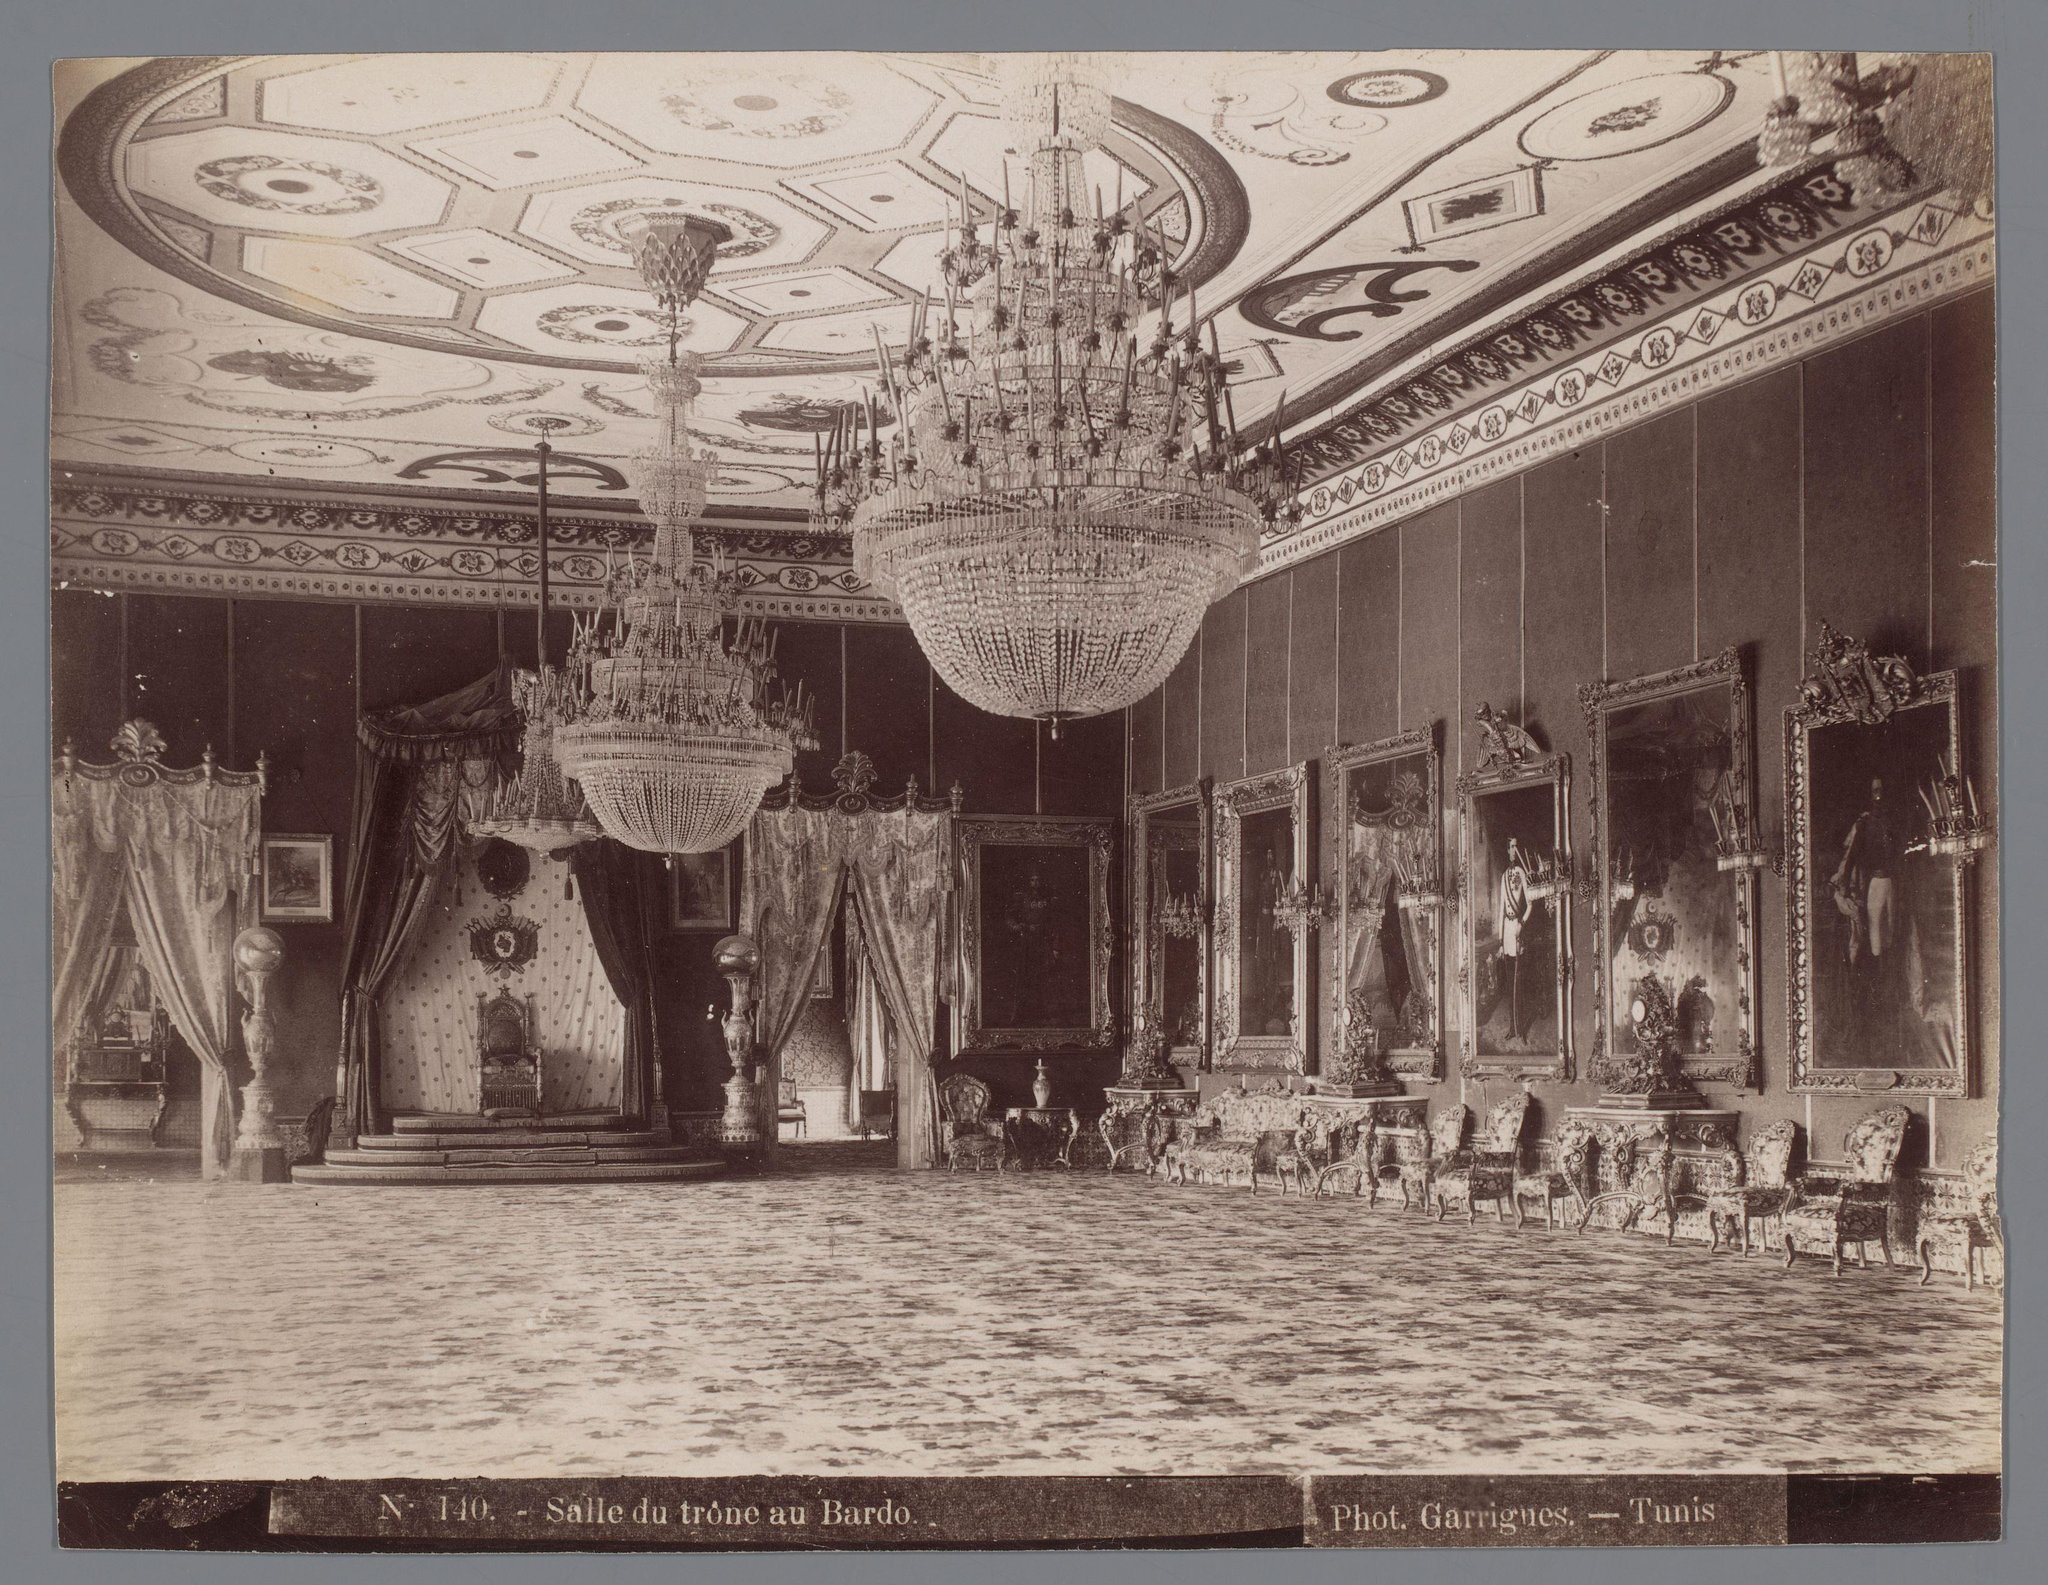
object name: photograph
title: Salle du trône au Bardo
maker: j. andré garrigues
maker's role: fotograaf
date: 1860-1900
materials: paper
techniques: albumen print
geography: le bardo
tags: throne-room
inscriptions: number: ‘N. 140.’